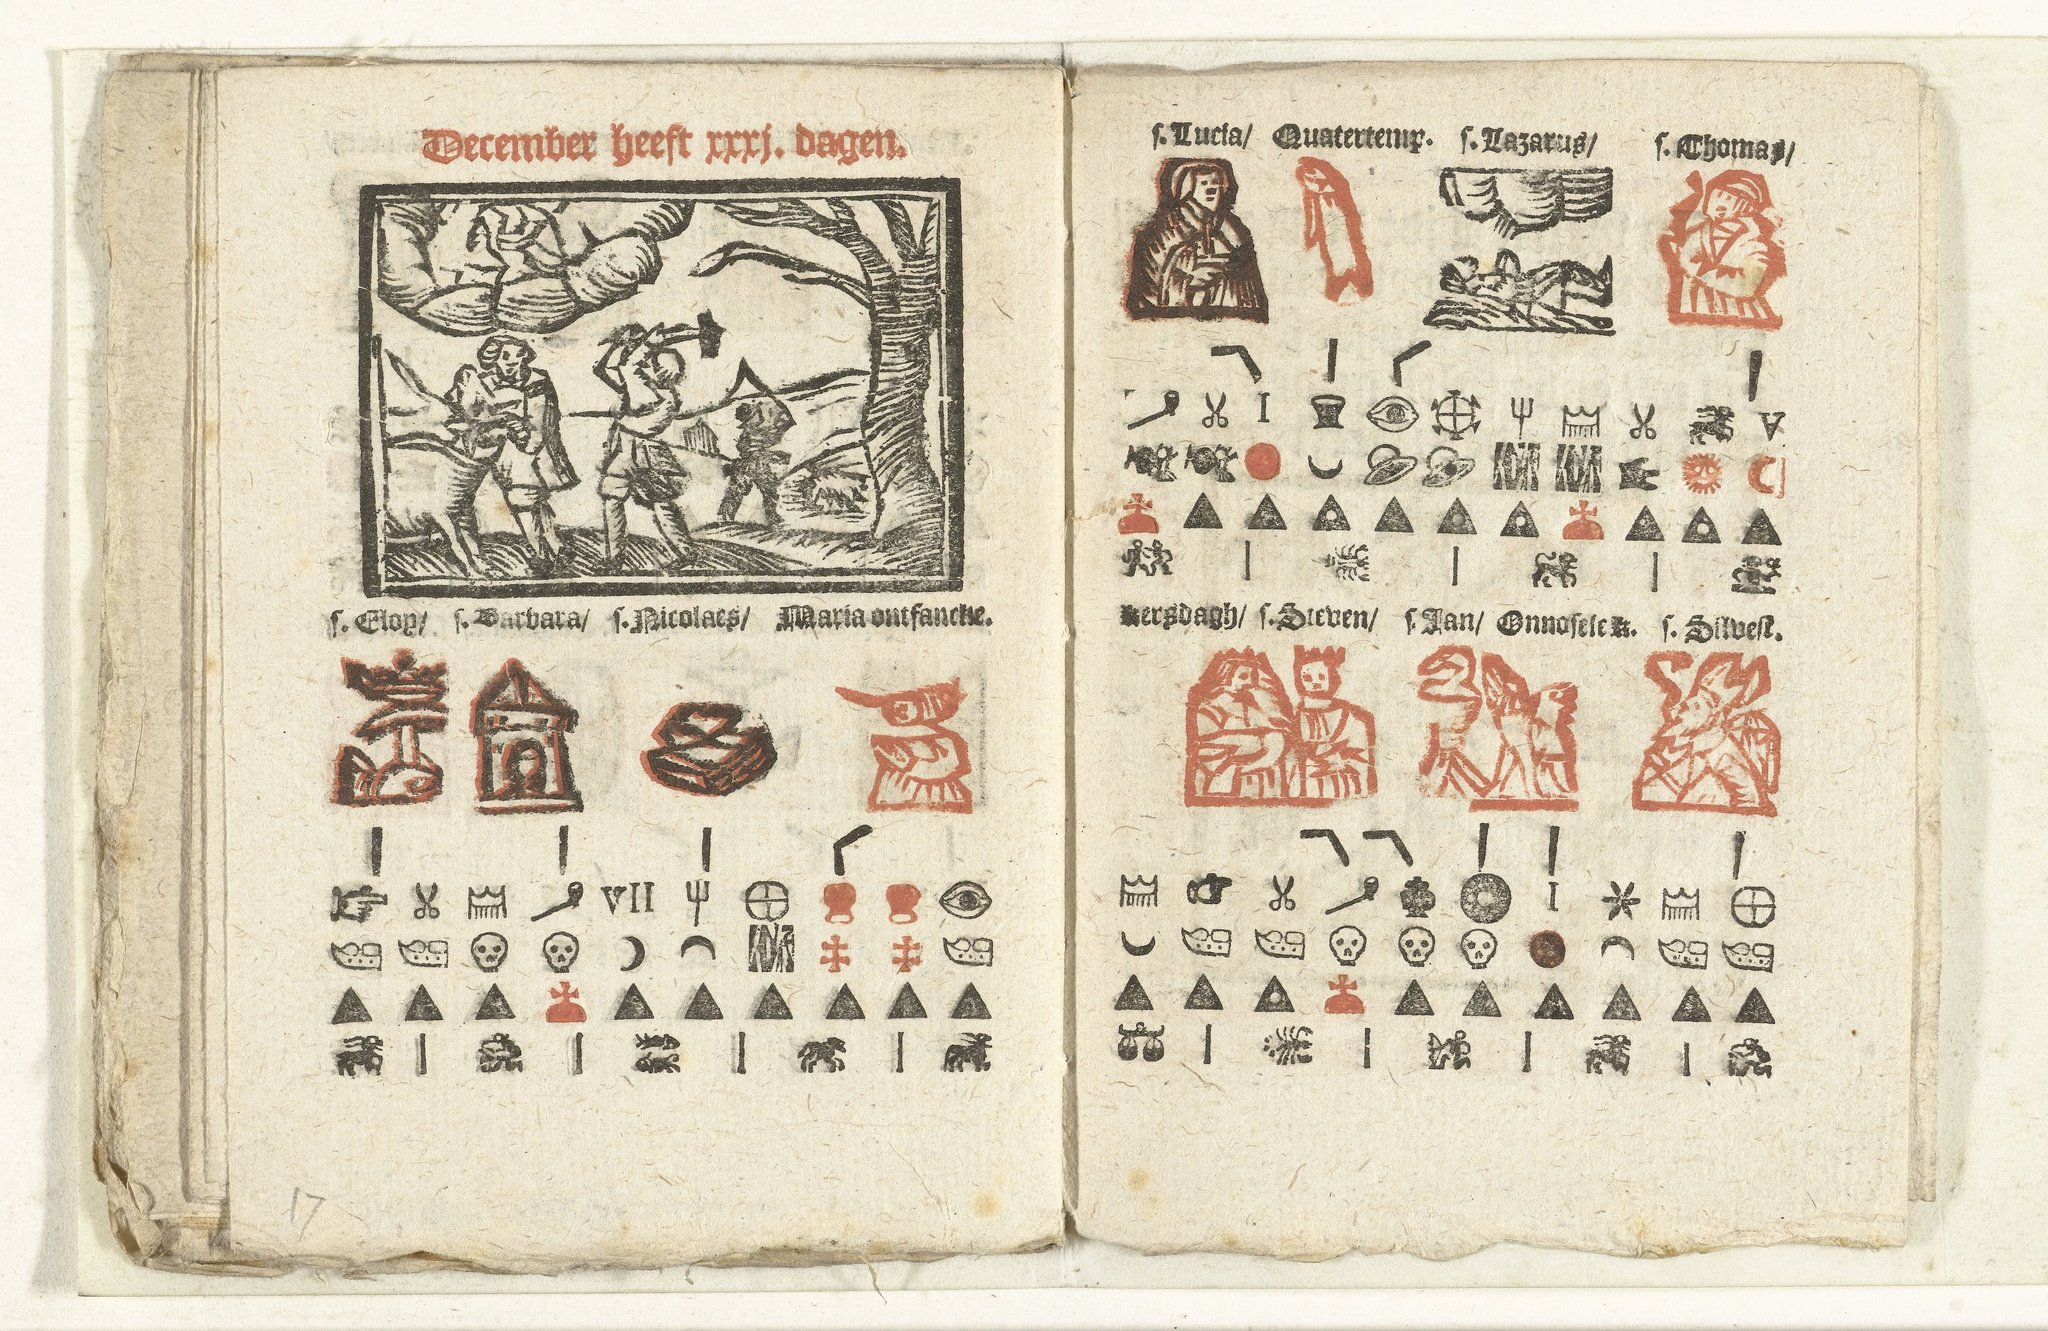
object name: book illustration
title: Bladzijden met de voorspelling voor de maand december, 1712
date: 1712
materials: paper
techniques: letterpress printing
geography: southern netherlands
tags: december and its 'labours' (+ with zodiacal signs)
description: Bladzijden in: Den Boeren / Oft Schapers Almanach Voor 't Schrickel Jaer ins Heeren Jesu Christi, 1712. Antwerpen: bij Wed. Slegers 1712. Exemplaar in de Rijksmuseum Research Library (signatuur: 305 G 19).